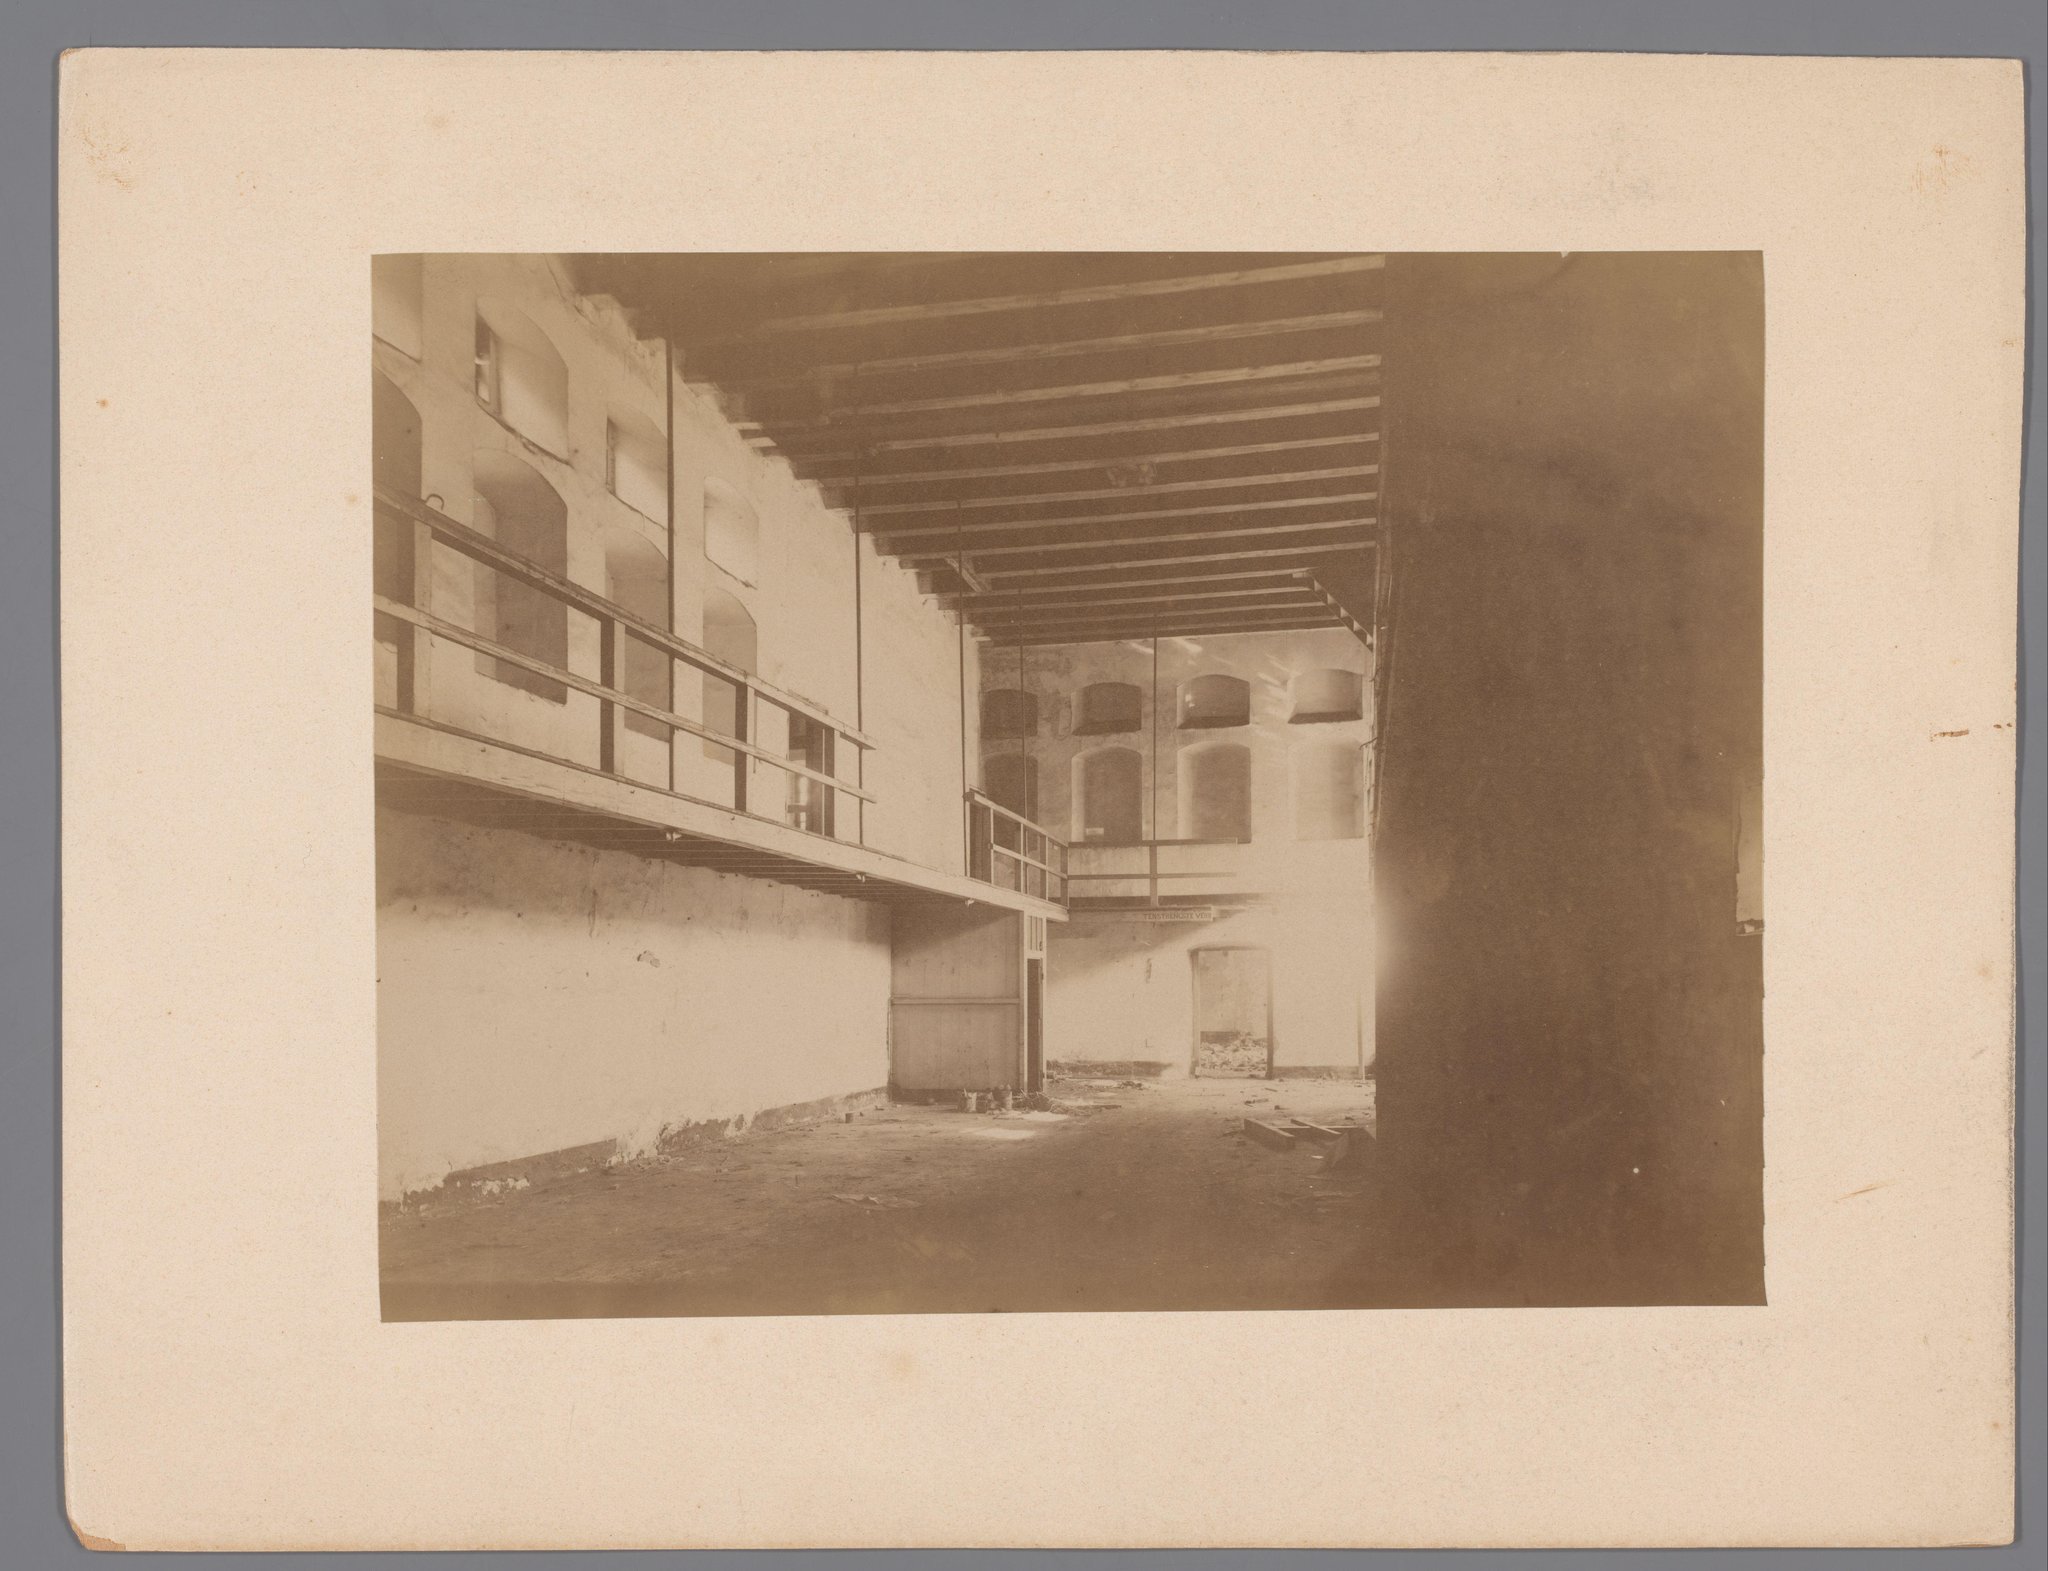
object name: photograph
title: Zaal van het Buitengasthuis te Amsterdam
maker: anoniem (monumentenzorg)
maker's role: fotograaf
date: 1900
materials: cardboard, photographic support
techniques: albumen print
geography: buitengasthuis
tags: hospital, courtyard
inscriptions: annotation: ‘Buiten-gasthuis te Amsteram (N.H.)/ gezicht in een der zalen/ oct 1900’